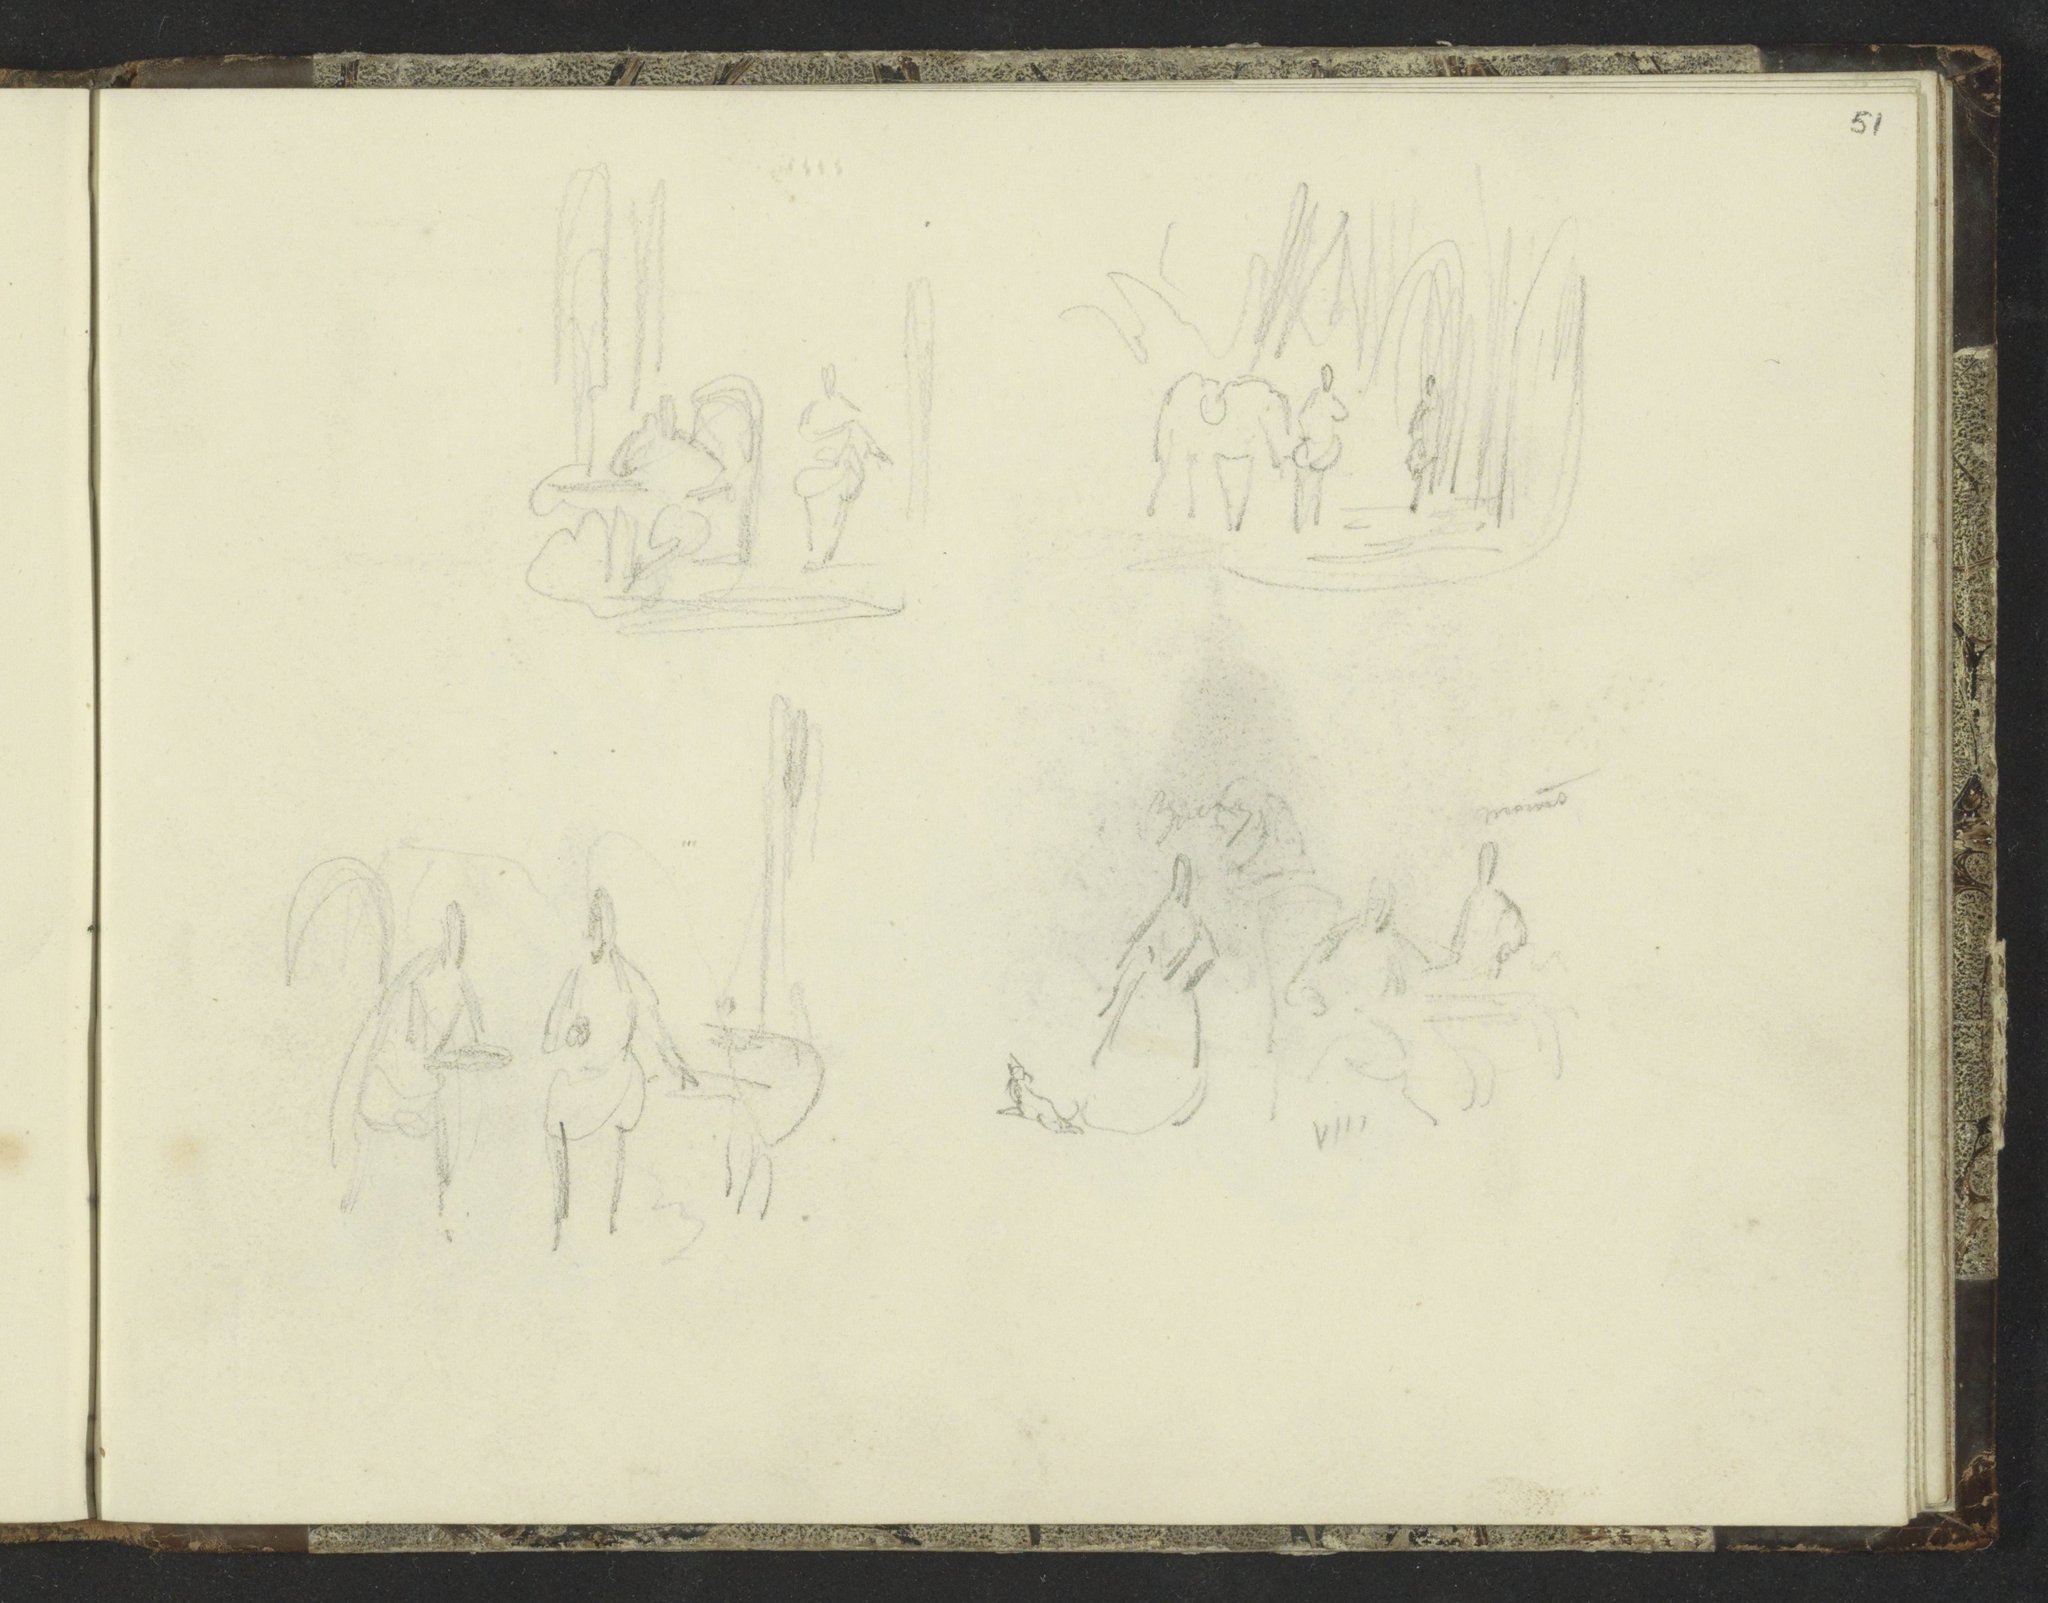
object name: sketchbook leaf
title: Studieblad met figuren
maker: willem hendrik schmidt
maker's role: draughtsman, painter, print maker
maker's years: 1809-1849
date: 1819-1849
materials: paper, pencil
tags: anatomy (non-medical)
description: Onder andere figuren aan tafels en figuren tegen een architecturale achtergrond. Blad 51 recto uit een schetsboek met 58 bladen.